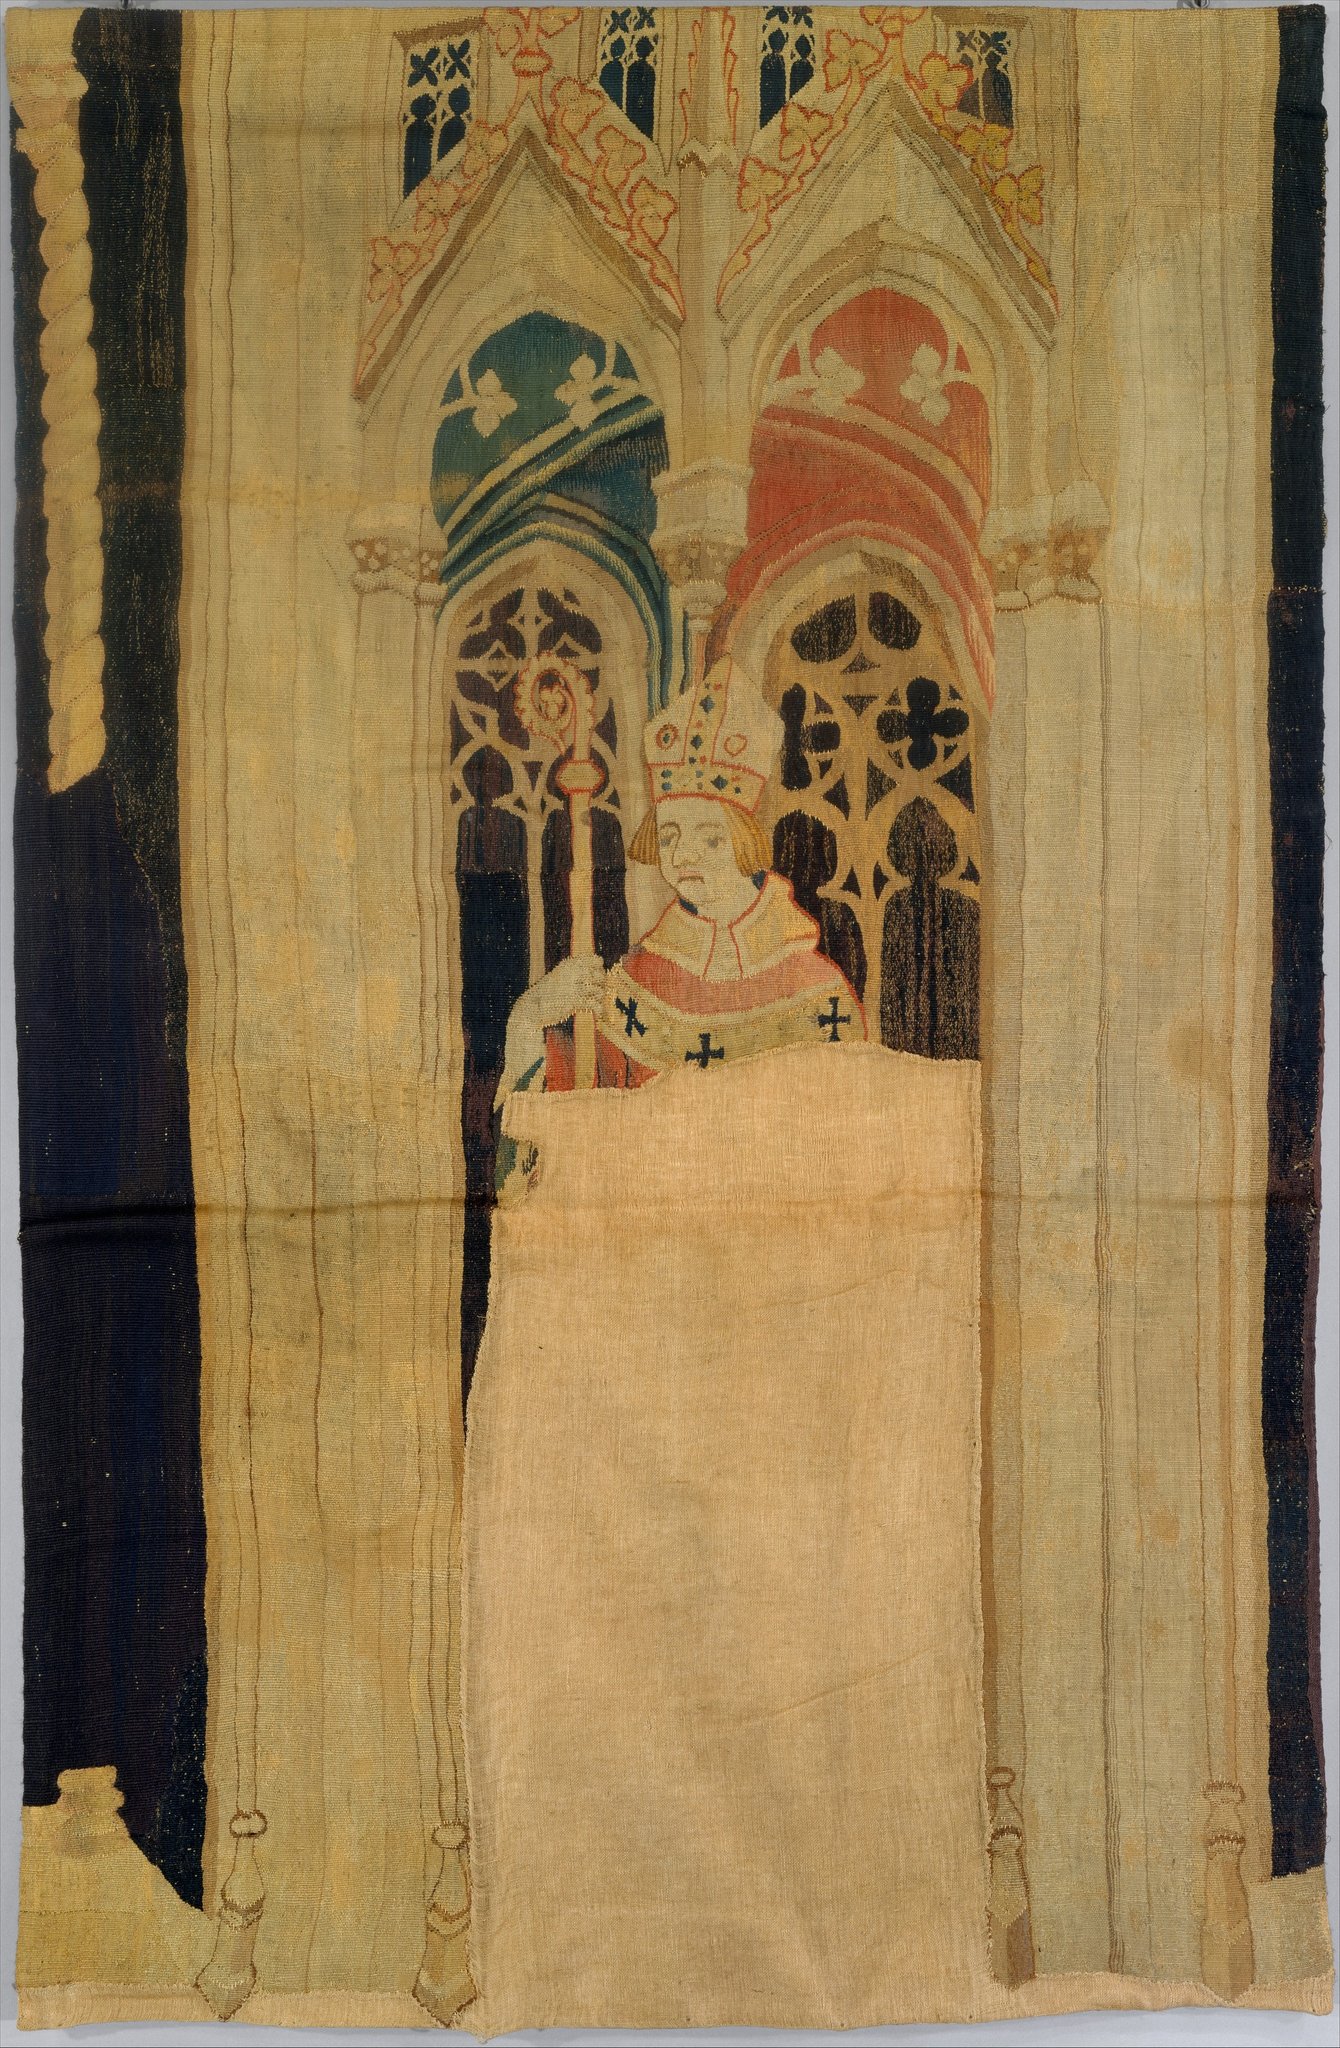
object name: tapestry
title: Fragment with Archbishop (from the Heroes Tapestries)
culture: south netherlandish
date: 1400-1410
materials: wool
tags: men